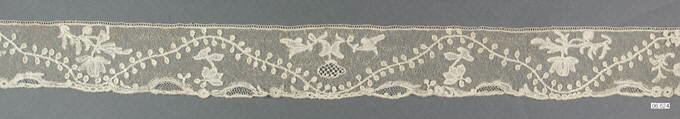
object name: strip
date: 1701-1800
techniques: lace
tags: flowers